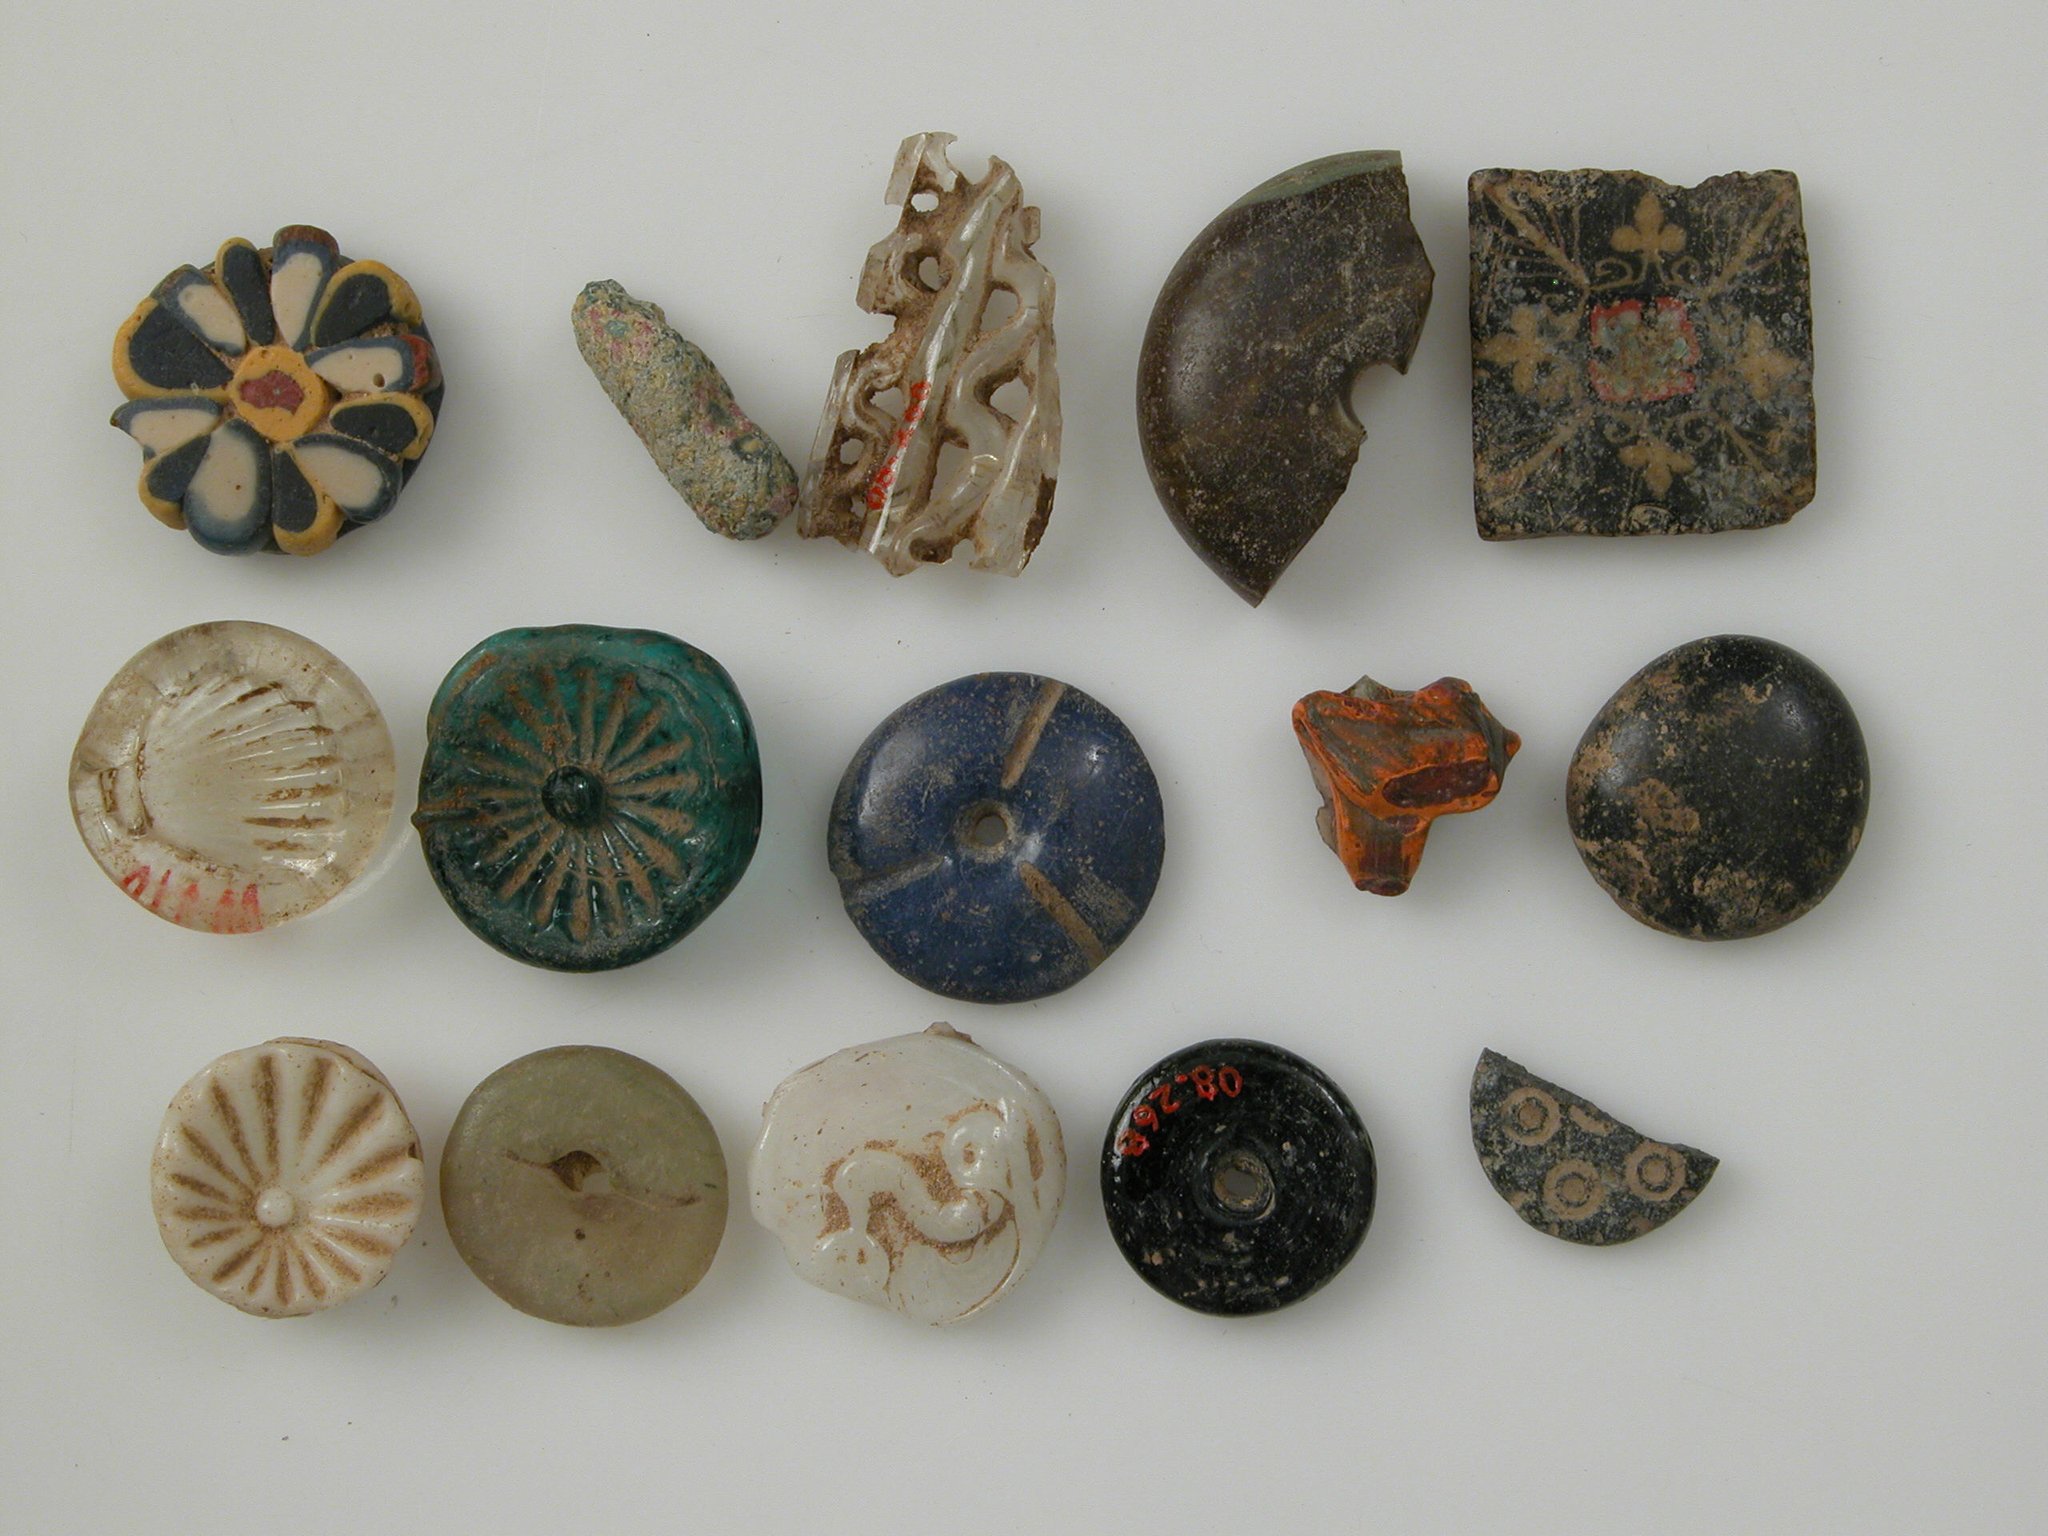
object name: fragment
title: Mosaic Glass Fragments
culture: coptic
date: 301-433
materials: glass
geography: egypt